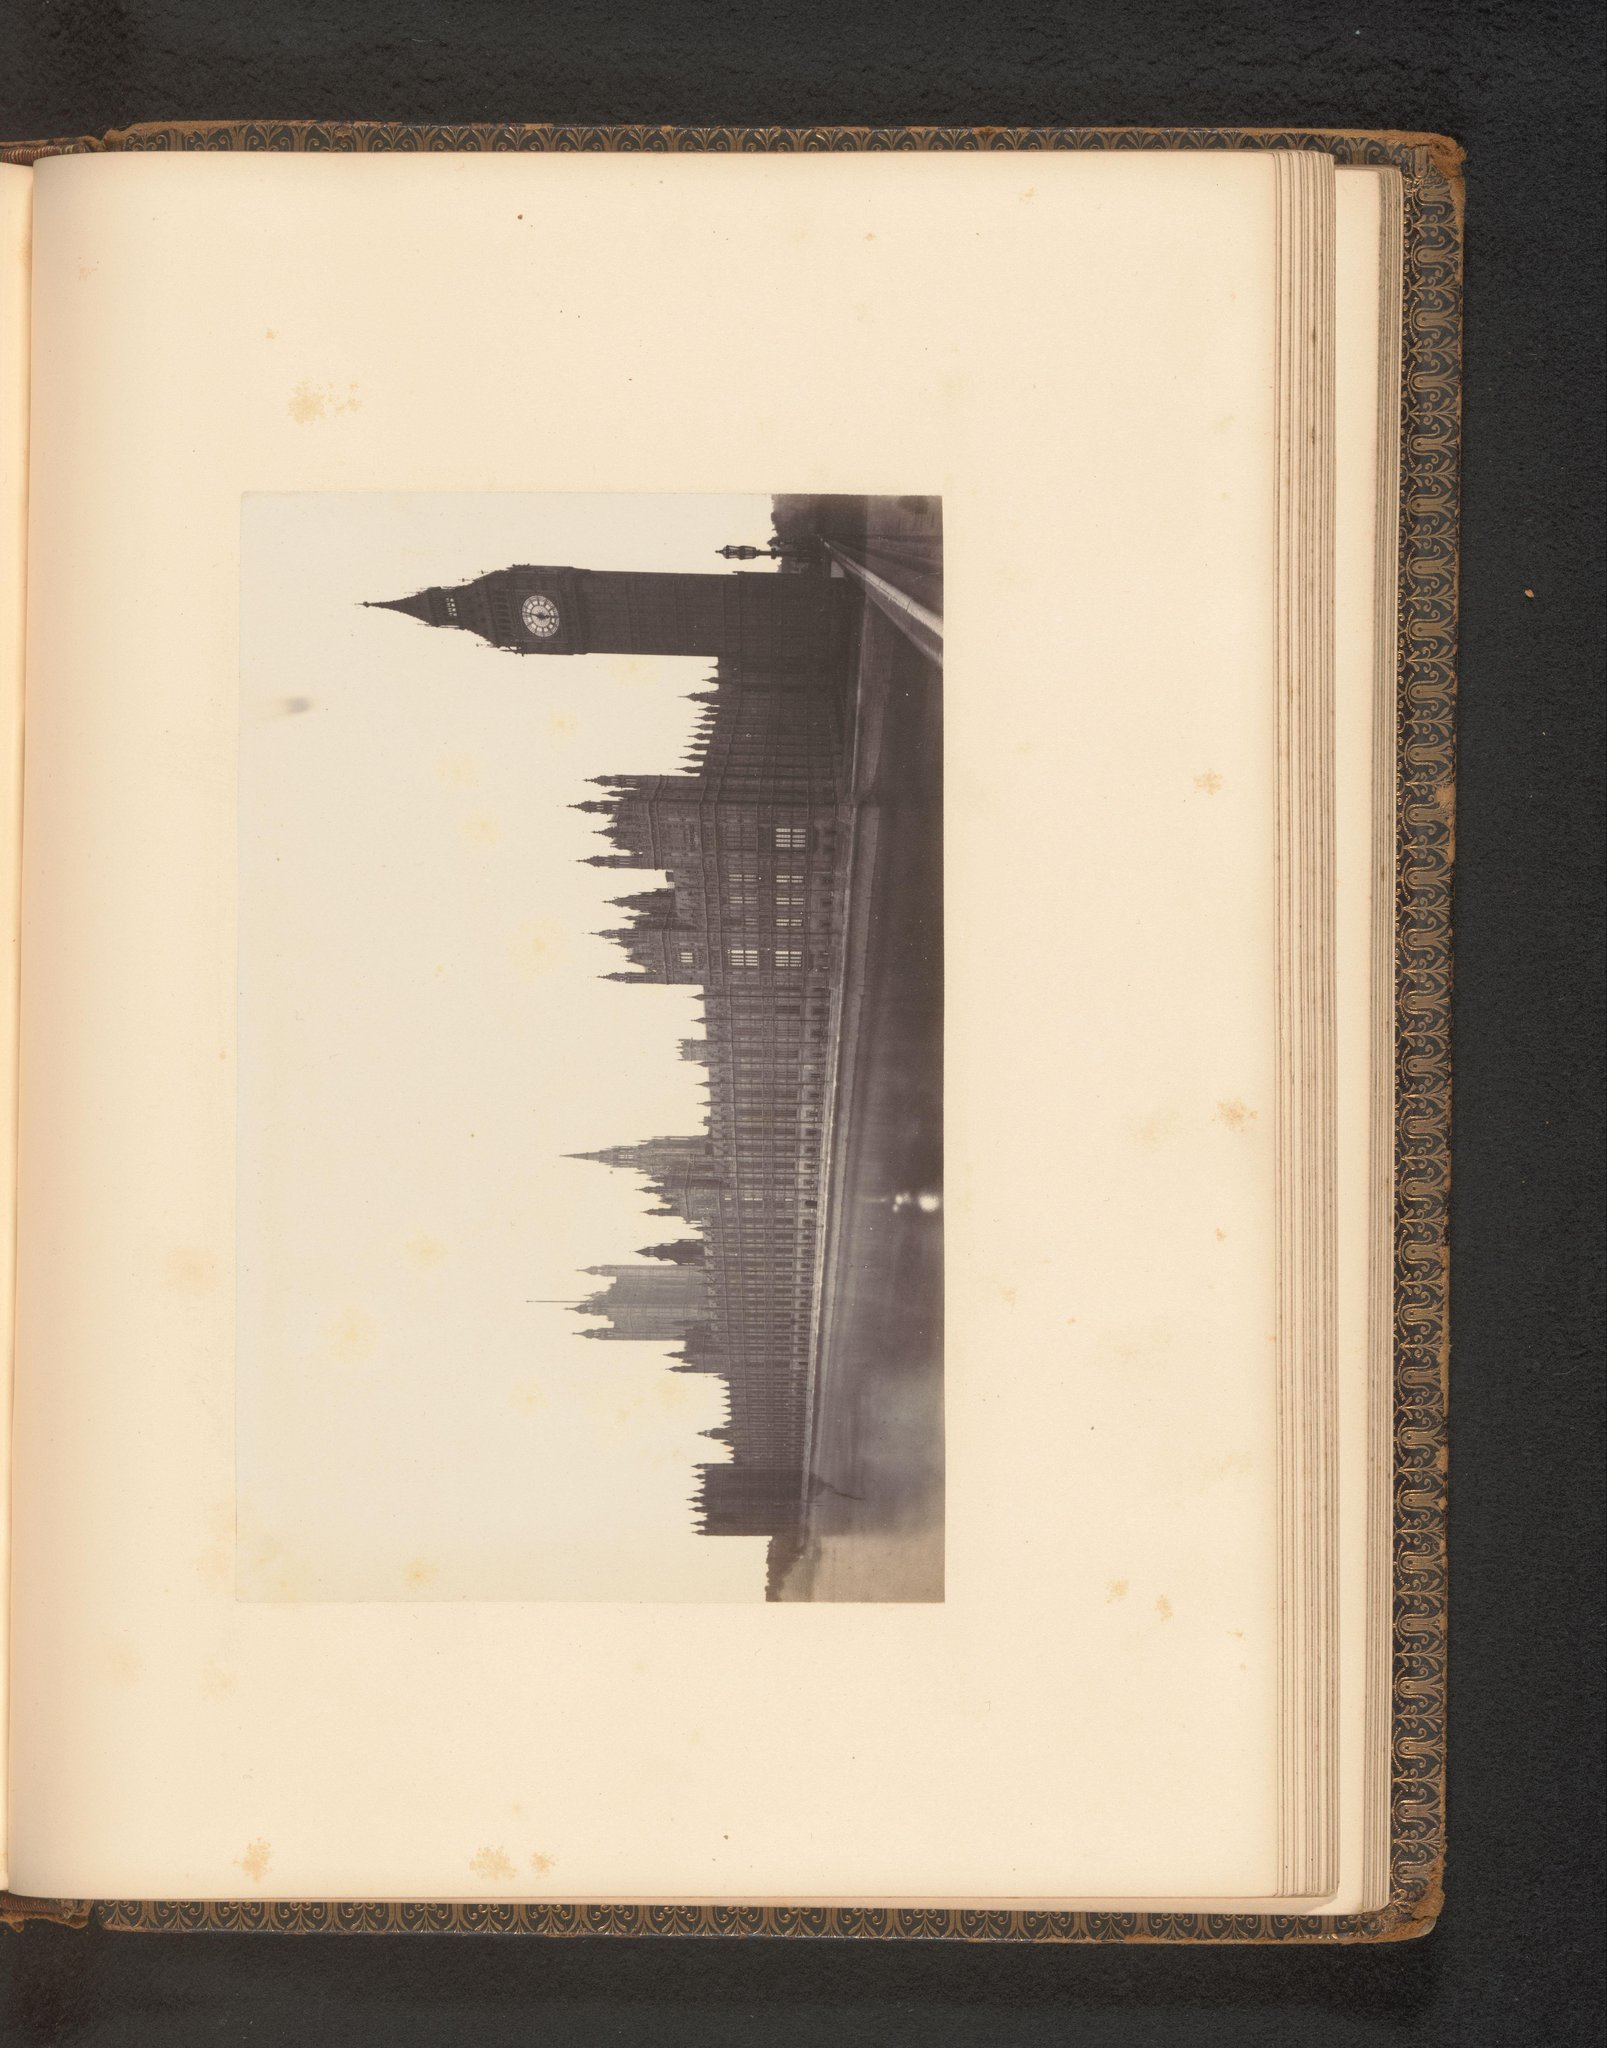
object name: page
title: Gezicht op Palace of Westminster aan de Theems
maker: john harrington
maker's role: fotograaf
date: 1864-1869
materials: photographic support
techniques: albumen print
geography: london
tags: river, palace